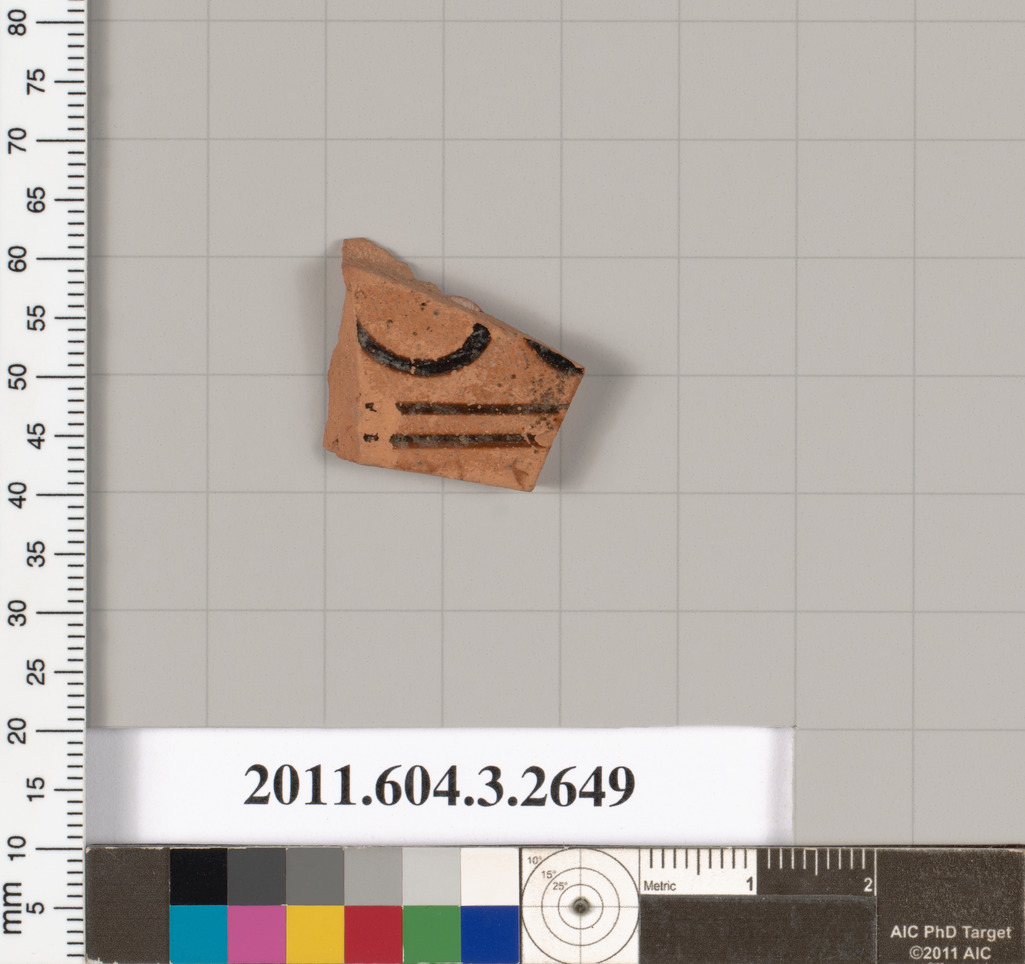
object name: undetermined closed shape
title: Terracotta fragment of a closed shape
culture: greek, attic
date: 600-501 BCE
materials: terracotta